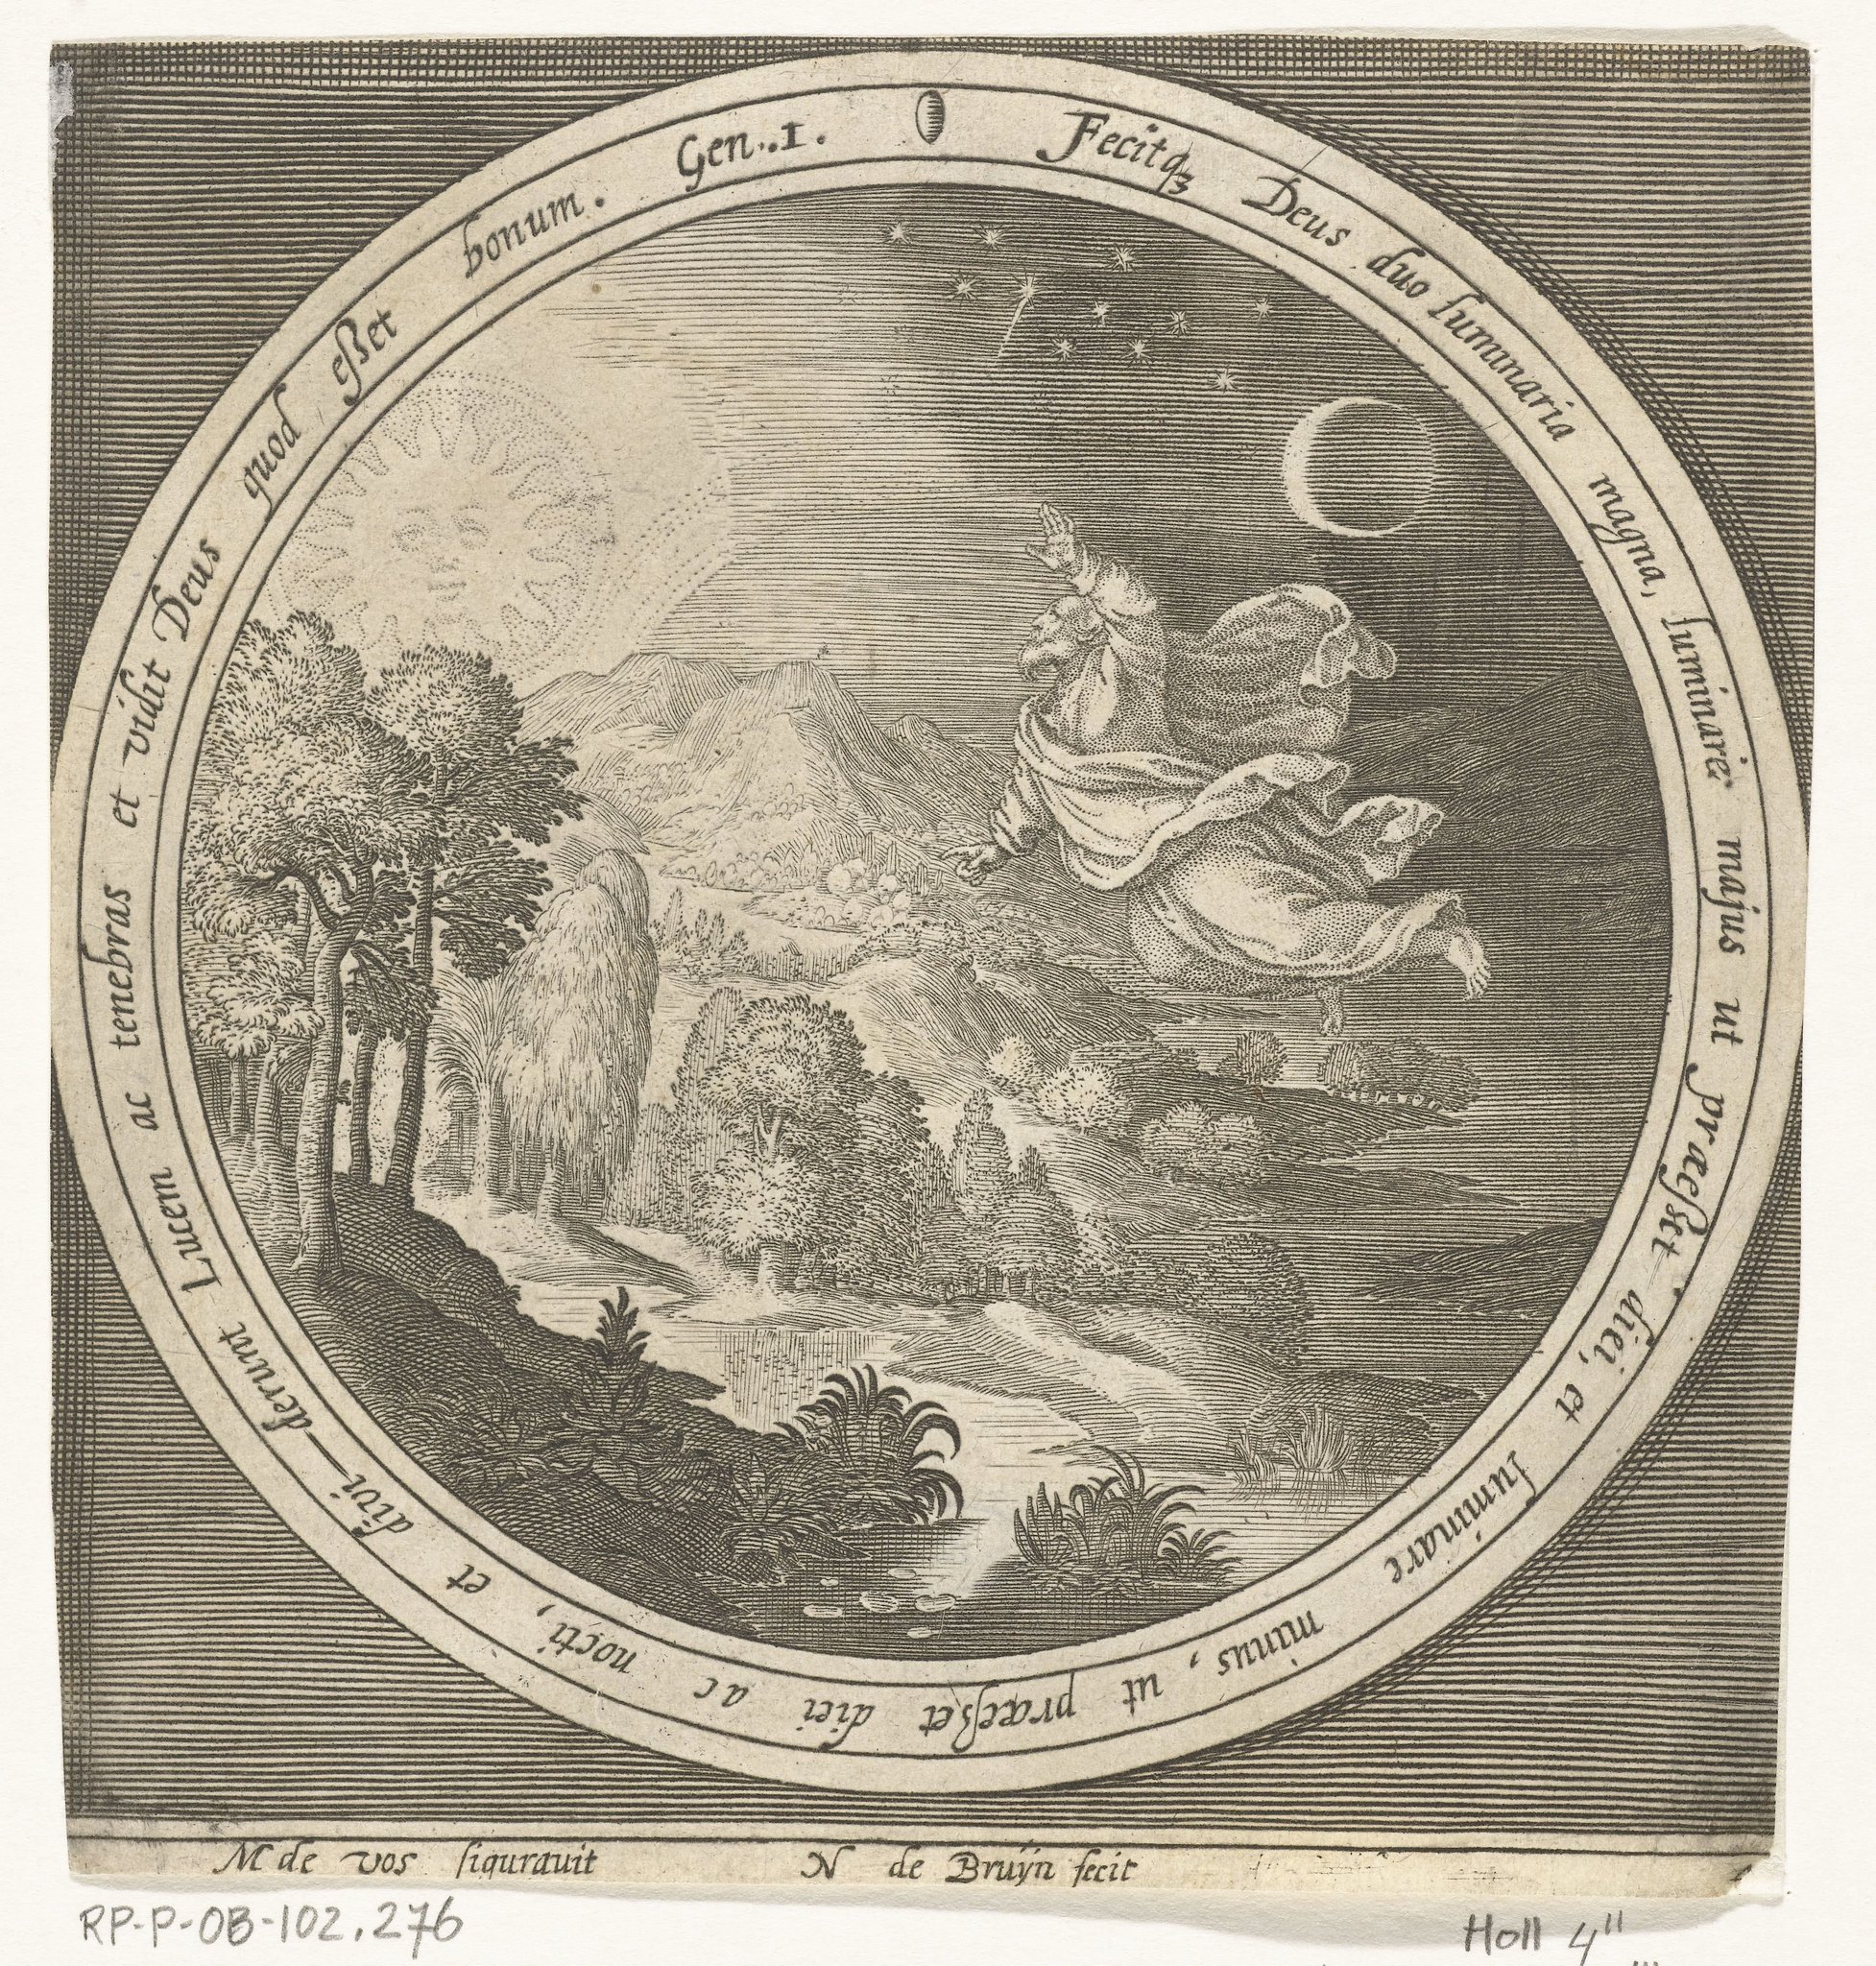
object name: print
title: Van schepping tot verdrijving uit paradijs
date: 1581-1656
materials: paper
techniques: engraving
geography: netherlands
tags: creation of sun, moon and stars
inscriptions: collector's mark: Lugt 2228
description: Vierde dag van schepping: God schept de zon, maan en sterren en scheidt zo het licht van de duisternis. In medaillon met als opschrift een bijbeltekst in Latijn uit Genesis 1 binnen rechthoekige omlijsting.